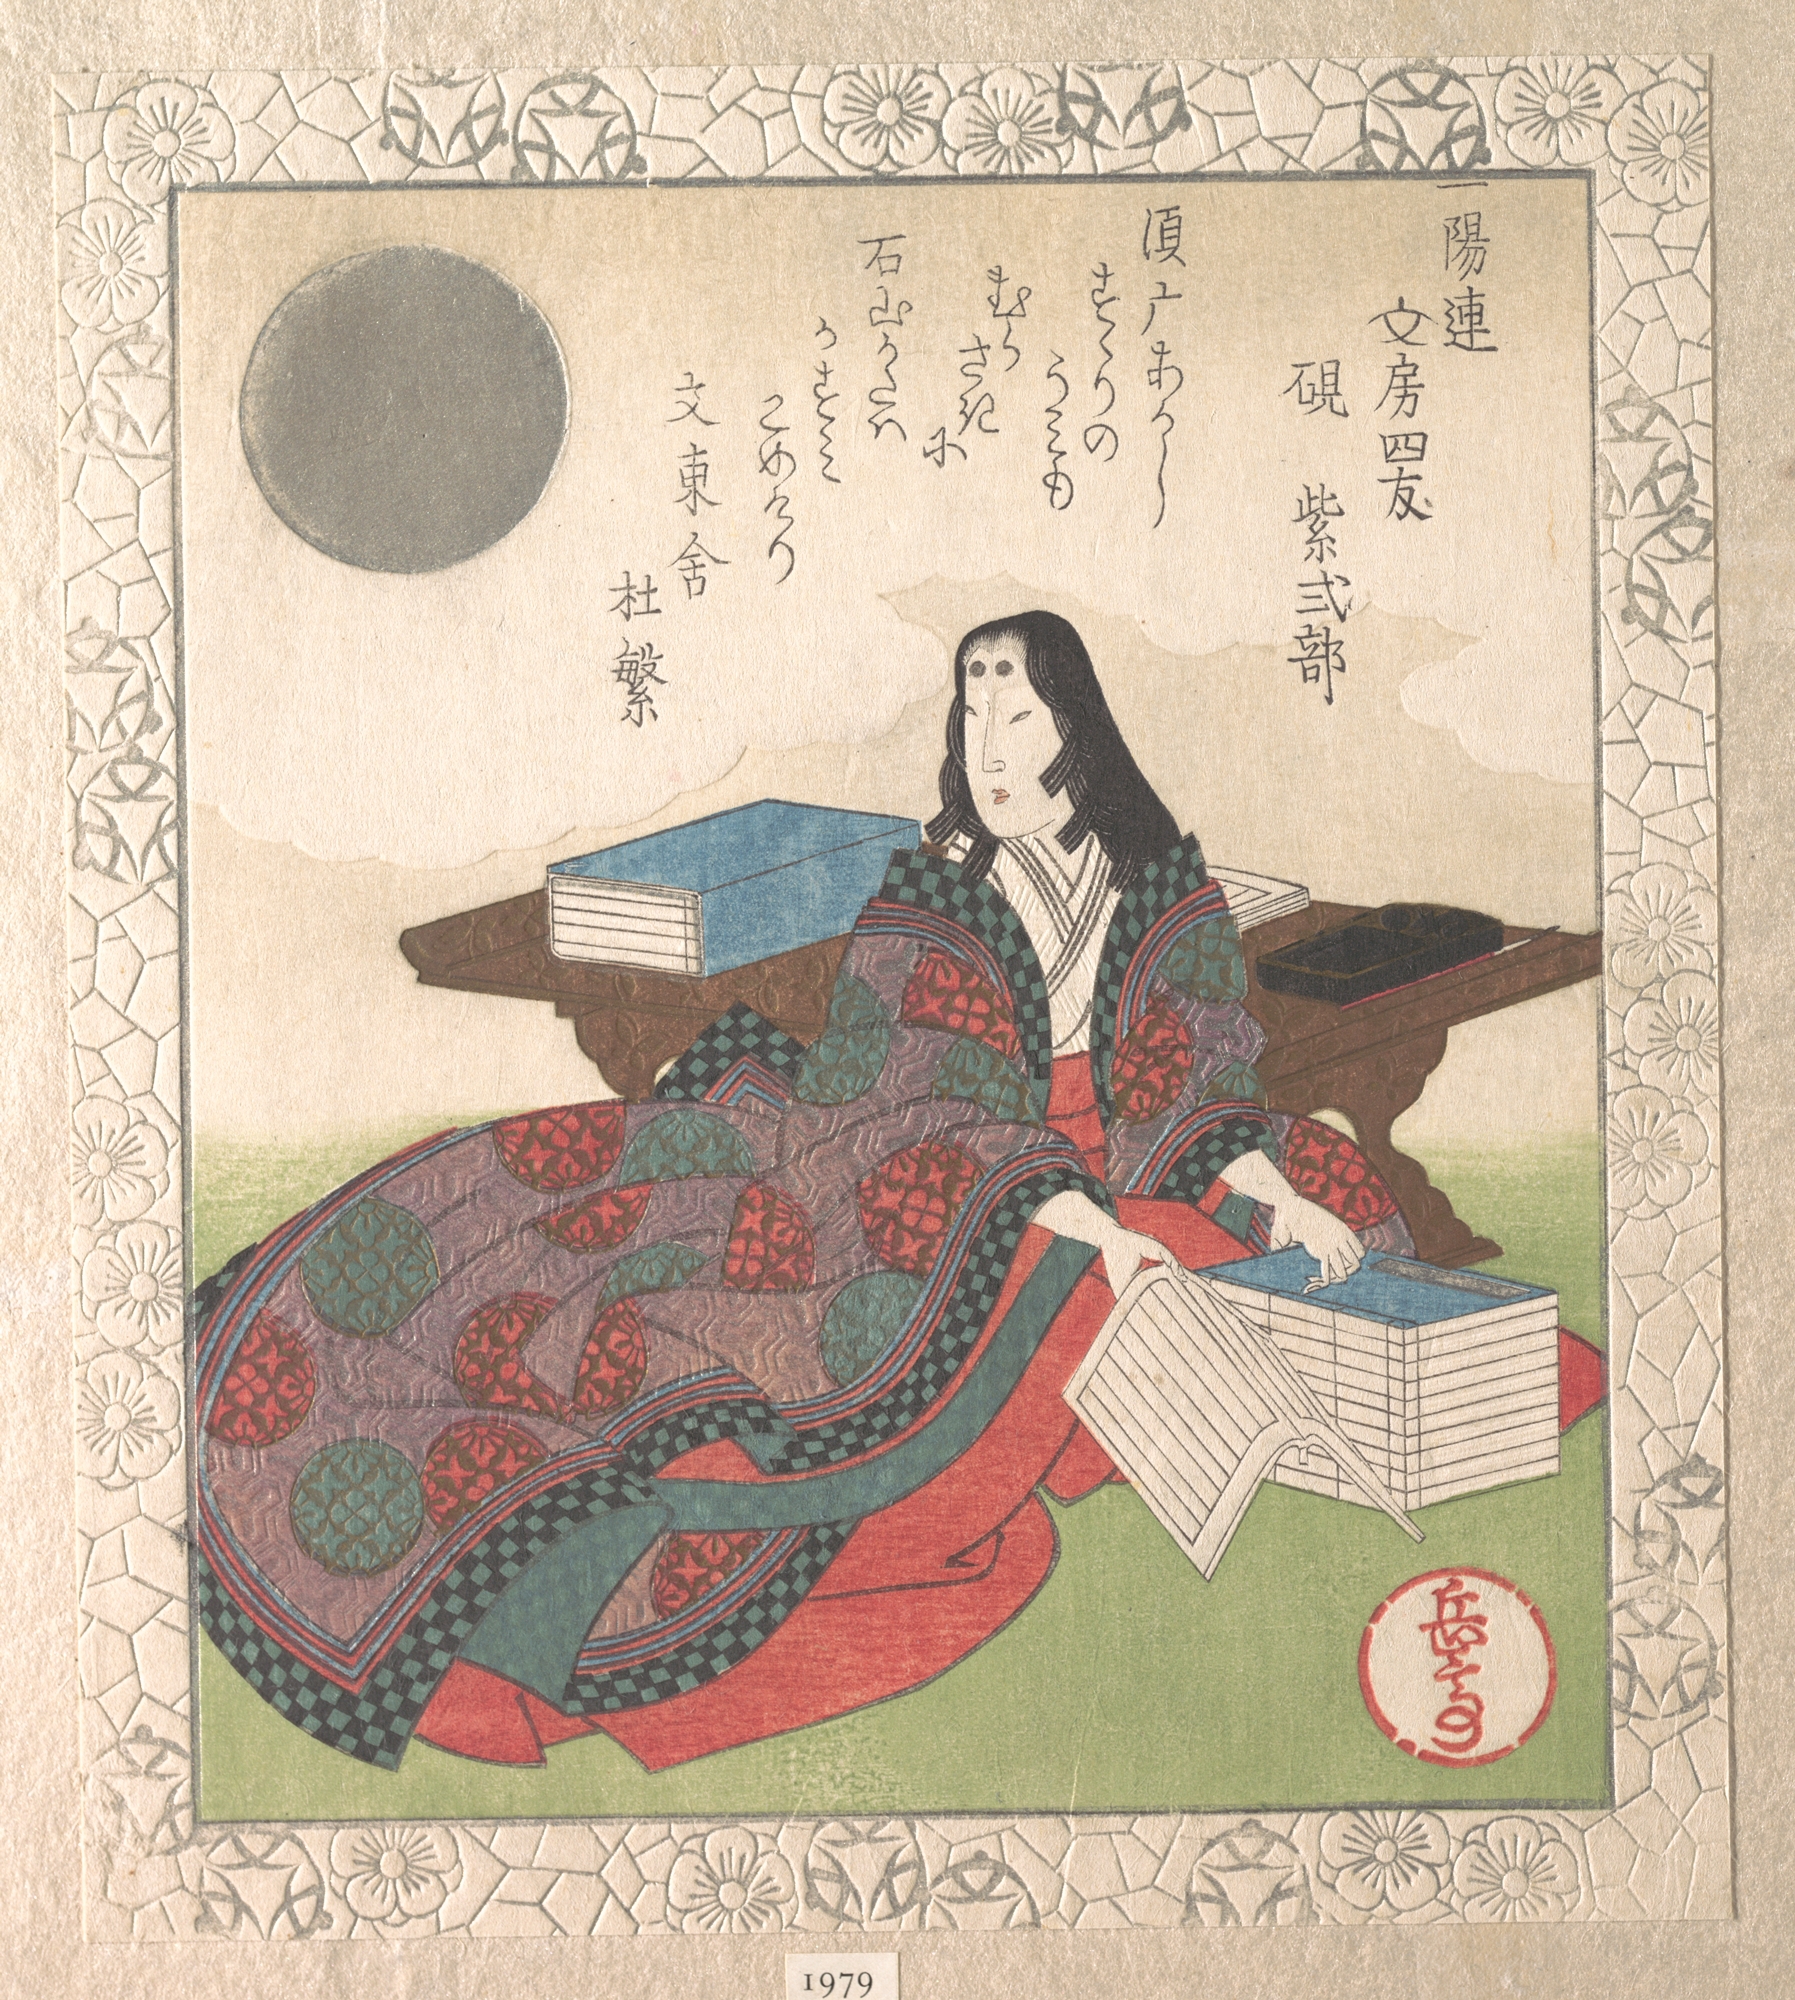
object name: print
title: Four Friends of Calligraphy: Lady Murasaki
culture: japanese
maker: yashima gakutei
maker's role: artist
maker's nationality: japanese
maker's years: 1786-1868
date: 1801-1900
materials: ink, paper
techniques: surimono, woodblock print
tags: books,women